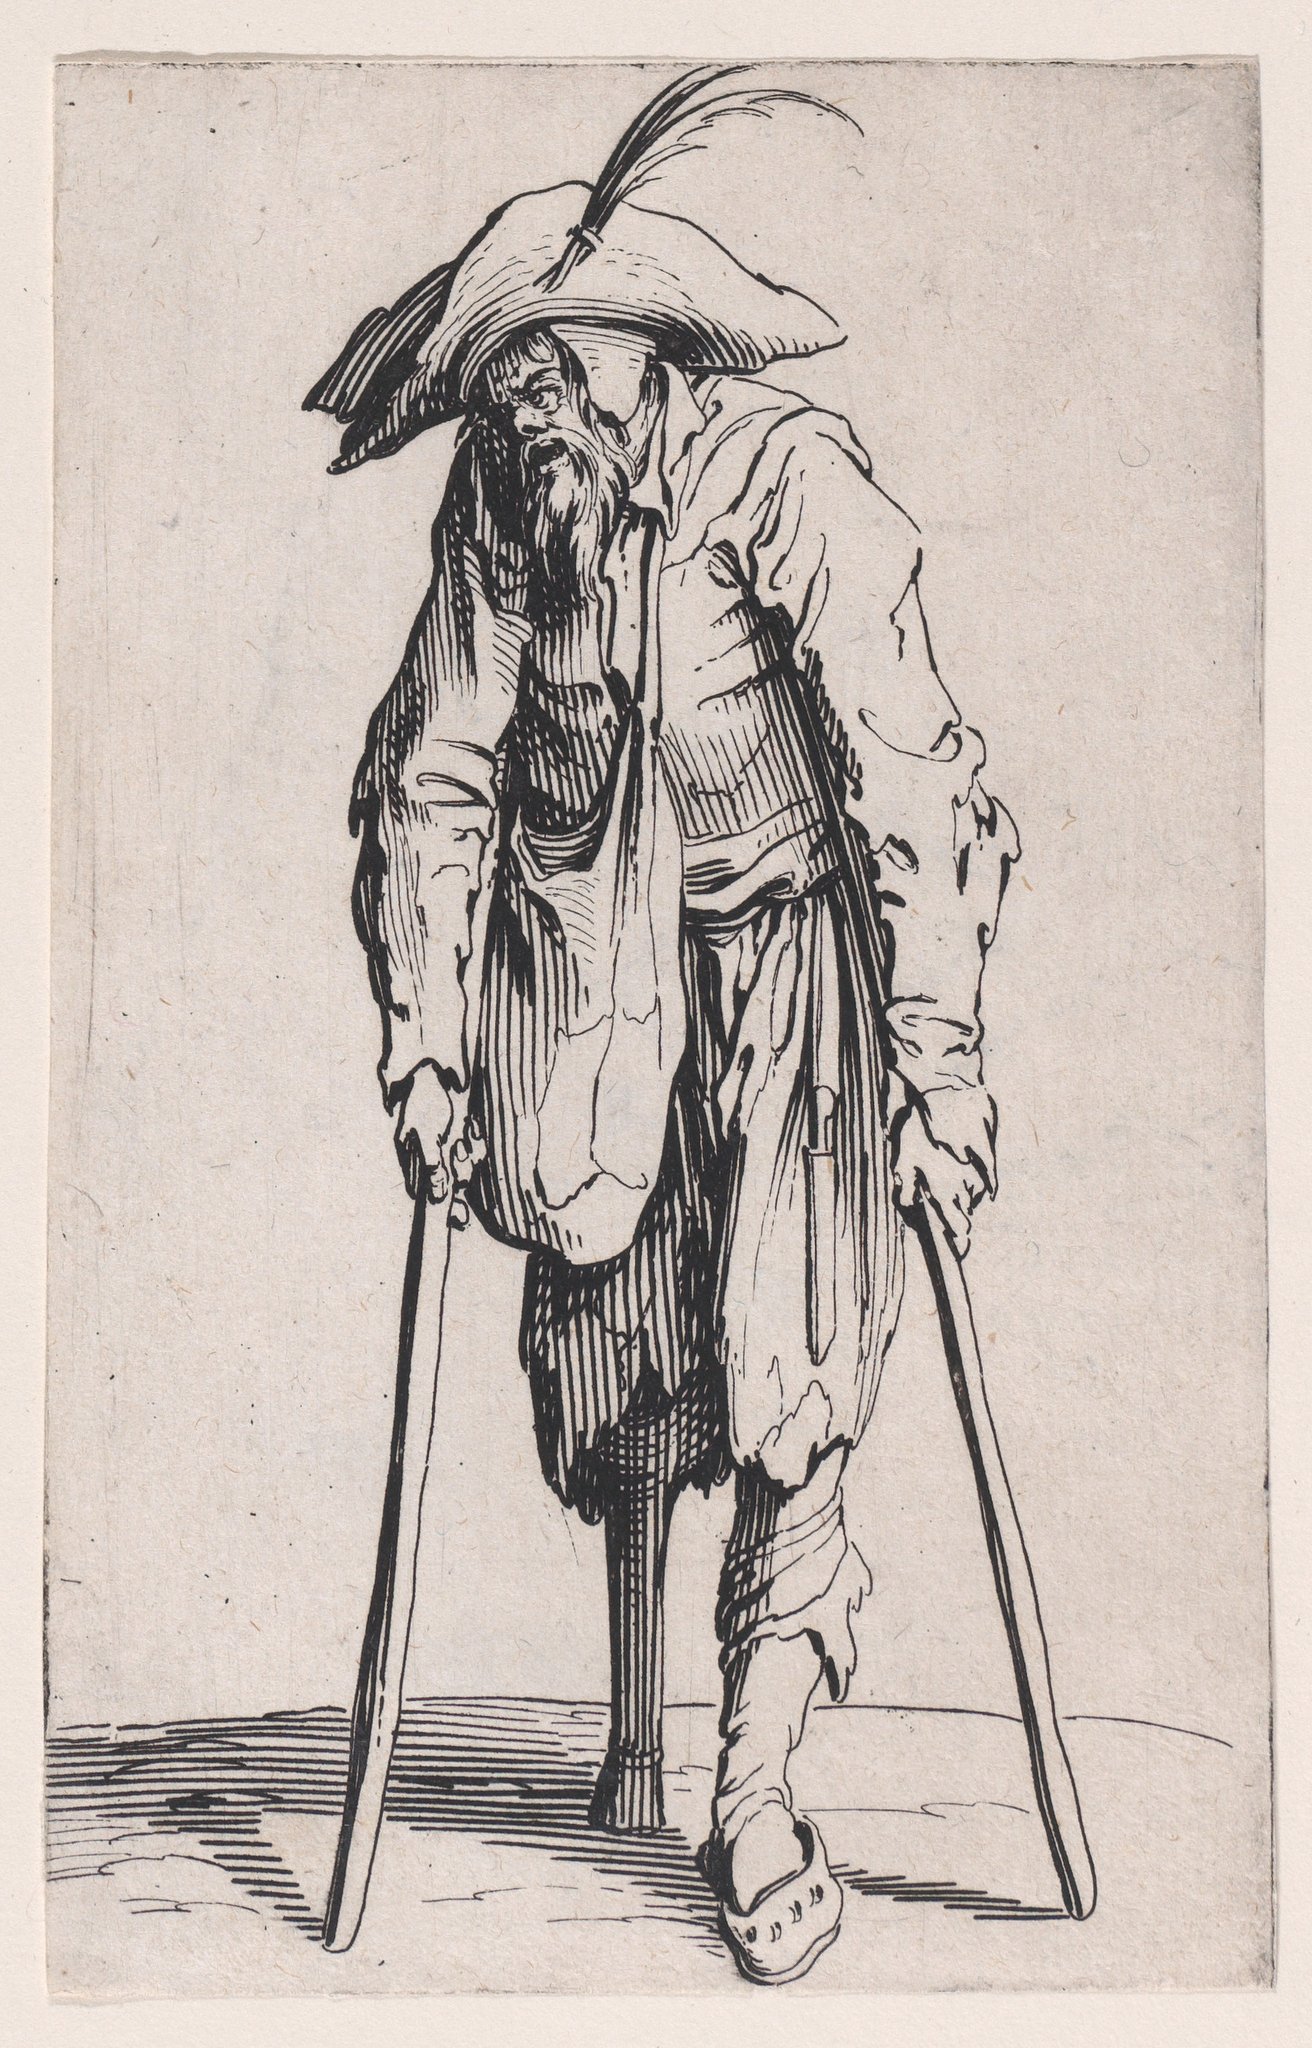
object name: print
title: Le Mendiant a la Jambe de Bois (The Beggar with a Wooden Leg), from "Les Gueux suite appelée aussi Les Mendiants, Les Baroni, ou Les Barons" (The Beggars, also called the Barons)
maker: jacques callot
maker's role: artist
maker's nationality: french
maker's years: 1592-1635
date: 1623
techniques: etching